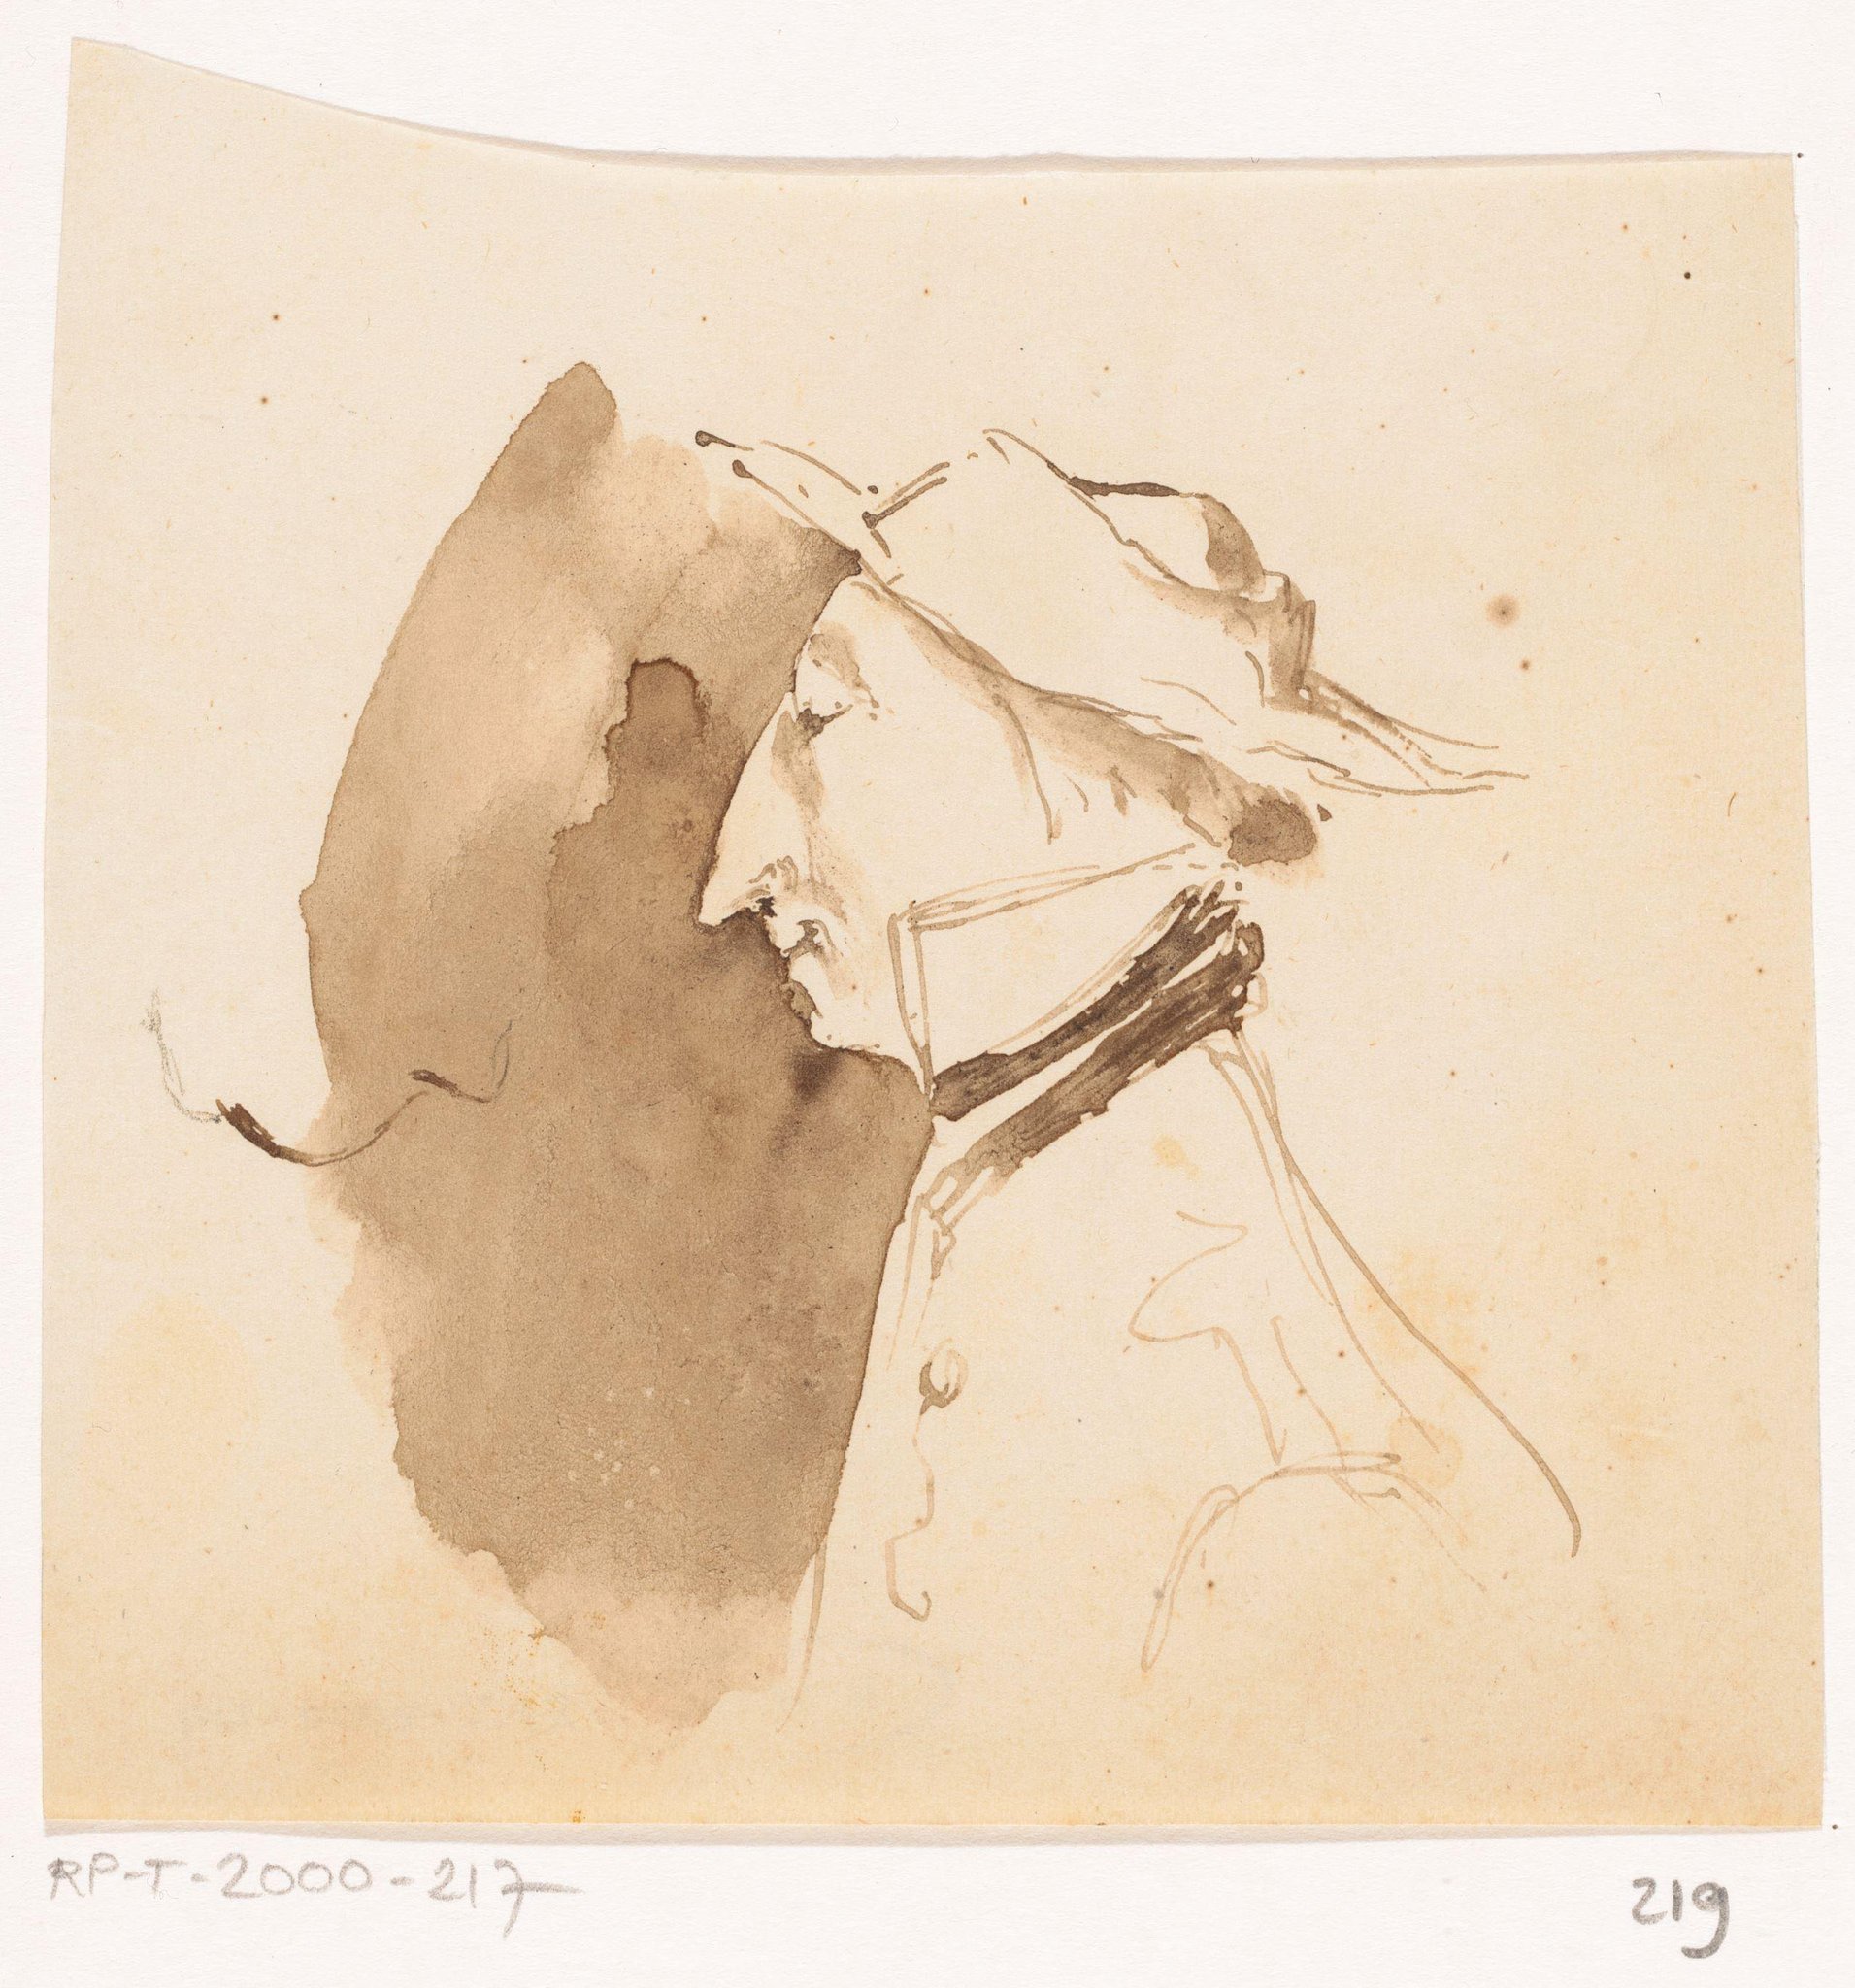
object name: drawing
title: Mansportret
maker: johannes tavenraat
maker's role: draughtsman, painter, print maker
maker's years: 1809-1881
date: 1840-1880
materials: ink, paper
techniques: brush, pen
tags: anonymous historical person portrayed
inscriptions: collector's mark: Lugt 2228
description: Portret van een man met hoed en opvallende neus, en profil naar links.